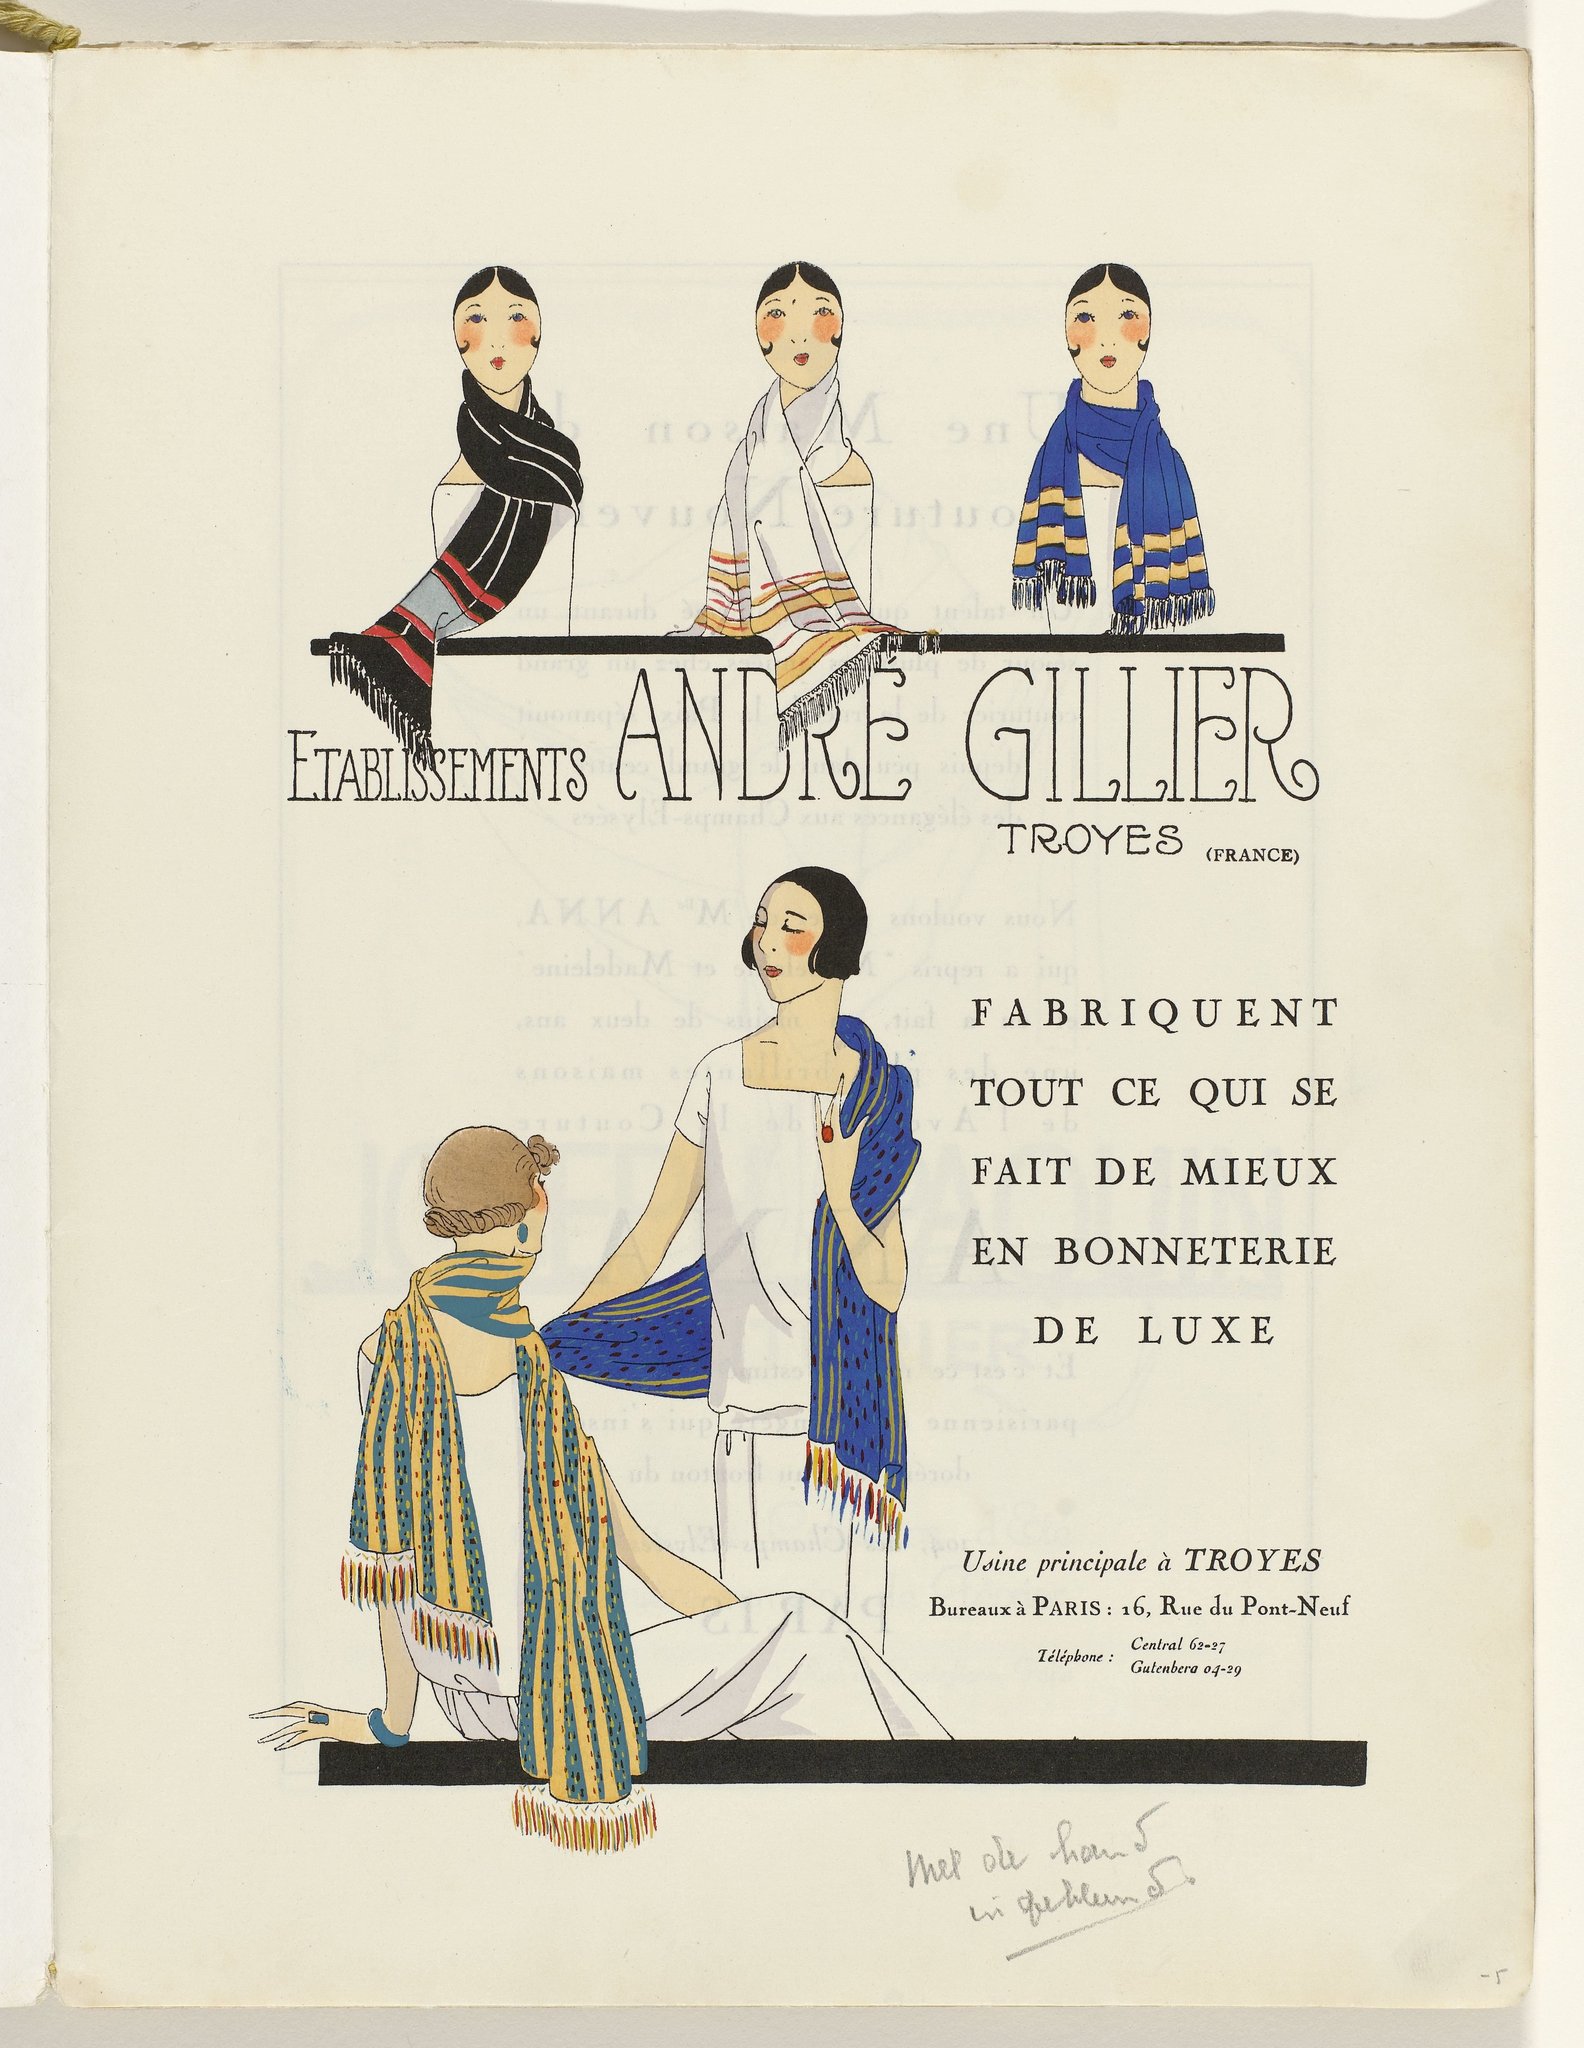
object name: fashion print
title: Art - Goût - Beauté, Feuillets de l' élégance féminine, Février 1926, No. 66, 6e Année, p. 5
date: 1926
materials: paper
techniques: hand coloring, lithograph, pochoir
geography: troyes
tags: clothing for the upper part of the body (shawl) (+ women's clothes), shop-window figures, fashion plates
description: Advertentie voor sjaals van Andre Gillier. Pagina uit het modetijdschrift Art-Goût-Beauté (1920-1933).